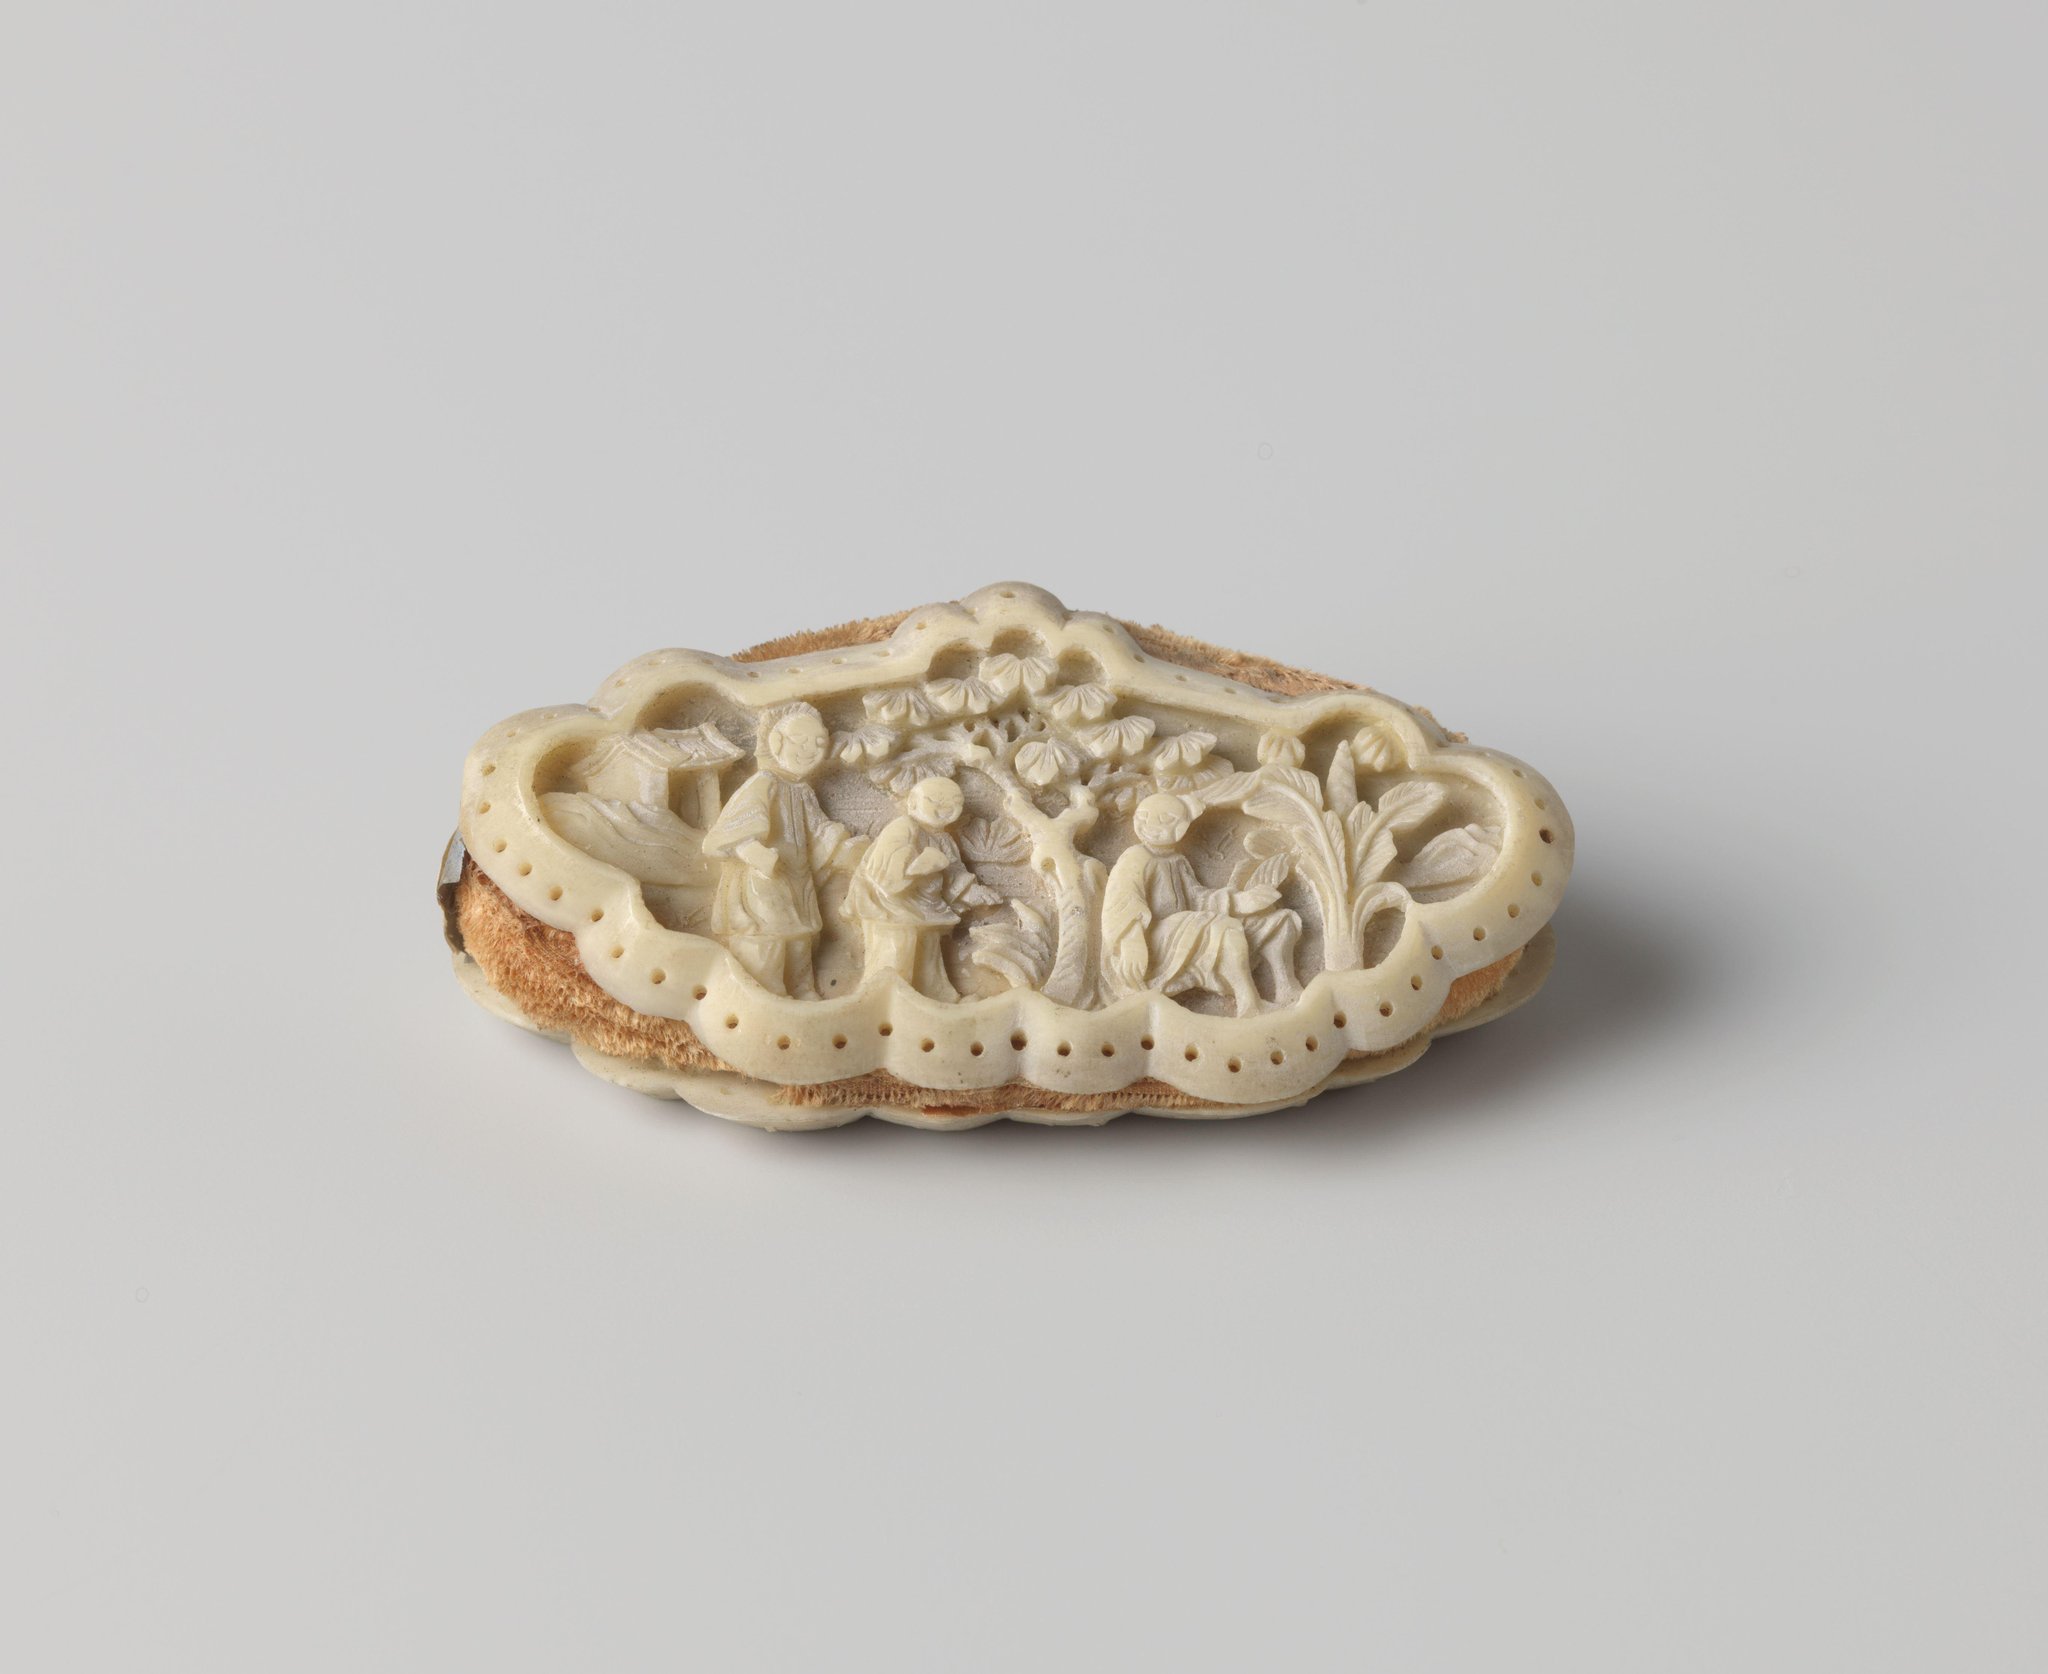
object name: pin cushion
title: Speldenkussen met onder- en bovenblad van ivoor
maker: Anonymous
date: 1825-1875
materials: ivory, velvet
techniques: cutting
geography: china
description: Speldenkussen met onder- en bovenblad van ivoor. De bladen hebben een geschulpte rand, waarin ter decoratie een rij eenvoudige gaatjes zijn geboord; daarbinnen Chinese dames bij een tafel in een landschap. Het kussen van (verkleurd) rood fluweel.